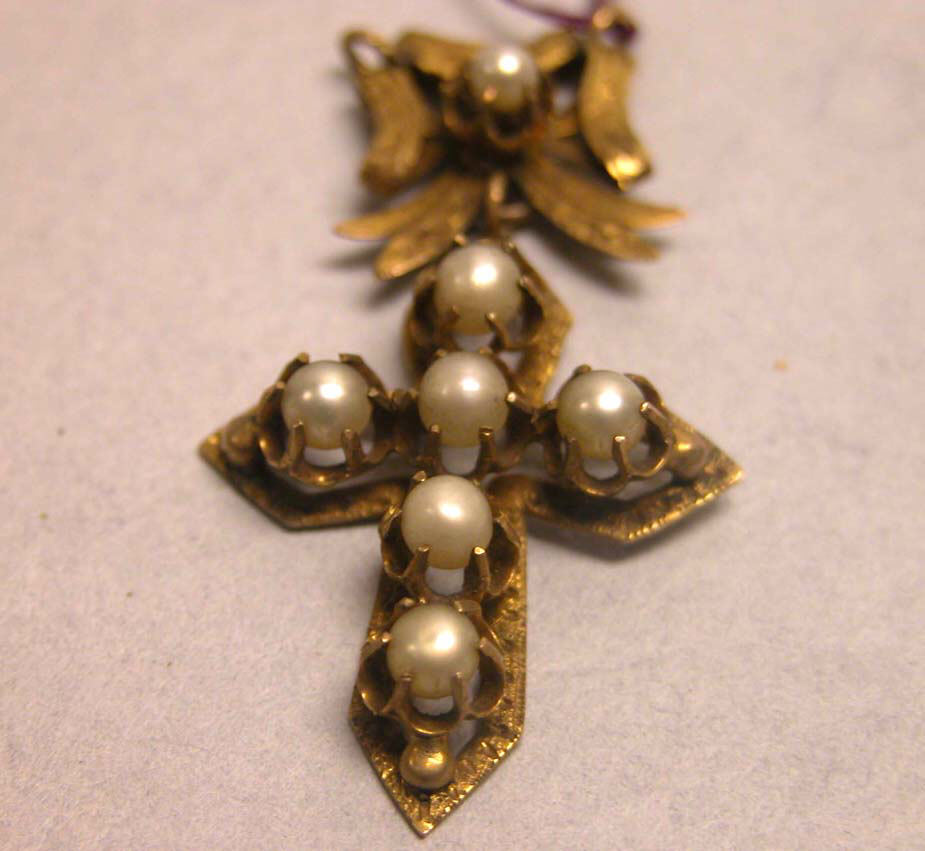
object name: cross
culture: filipino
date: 1601-1900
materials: gold, pearl